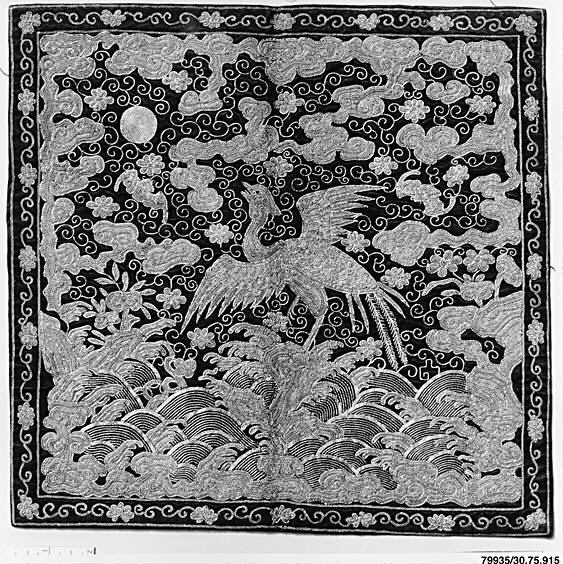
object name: rank badge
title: Rank Badge with Golden Pheasant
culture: chinese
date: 1767-1800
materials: metal thread, silk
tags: bats,pheasants